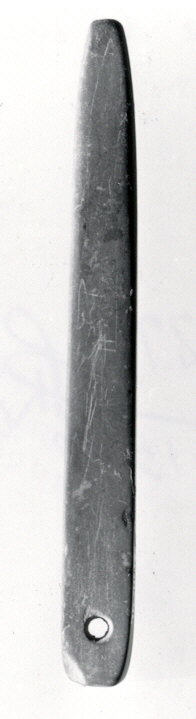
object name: whetstone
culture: sasanian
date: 201-700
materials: stone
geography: iran